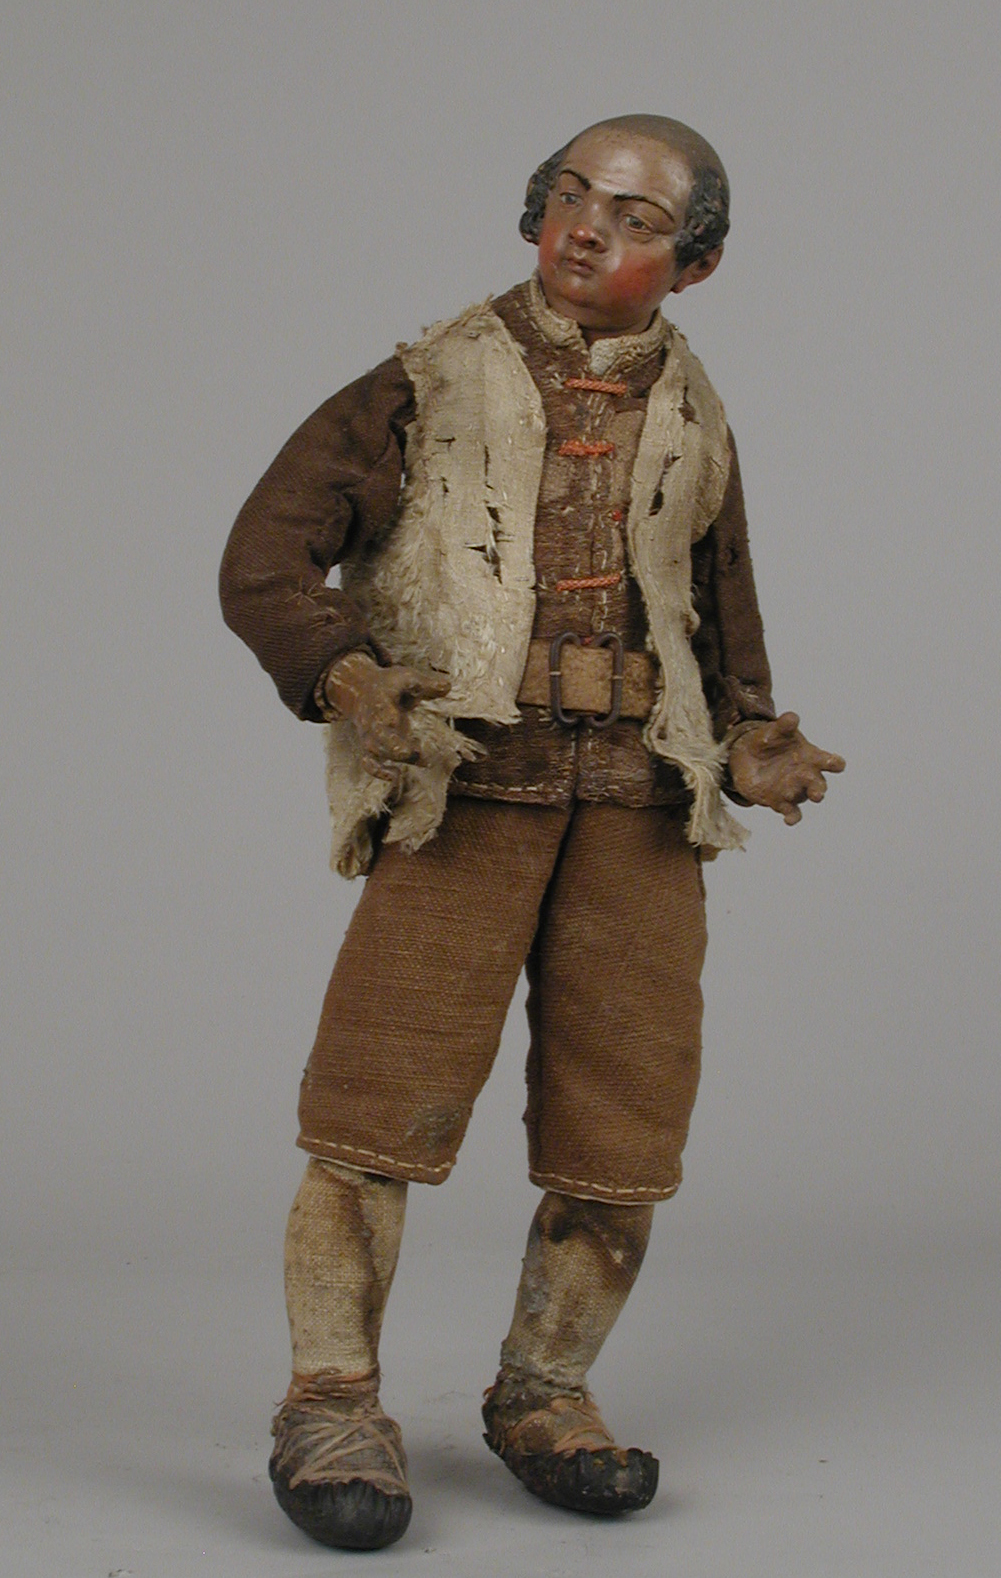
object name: crèche figure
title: Shepherd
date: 1751-1800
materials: cotton, leather, metal, silk, terracotta, fiber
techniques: polychrome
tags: men,shepherds